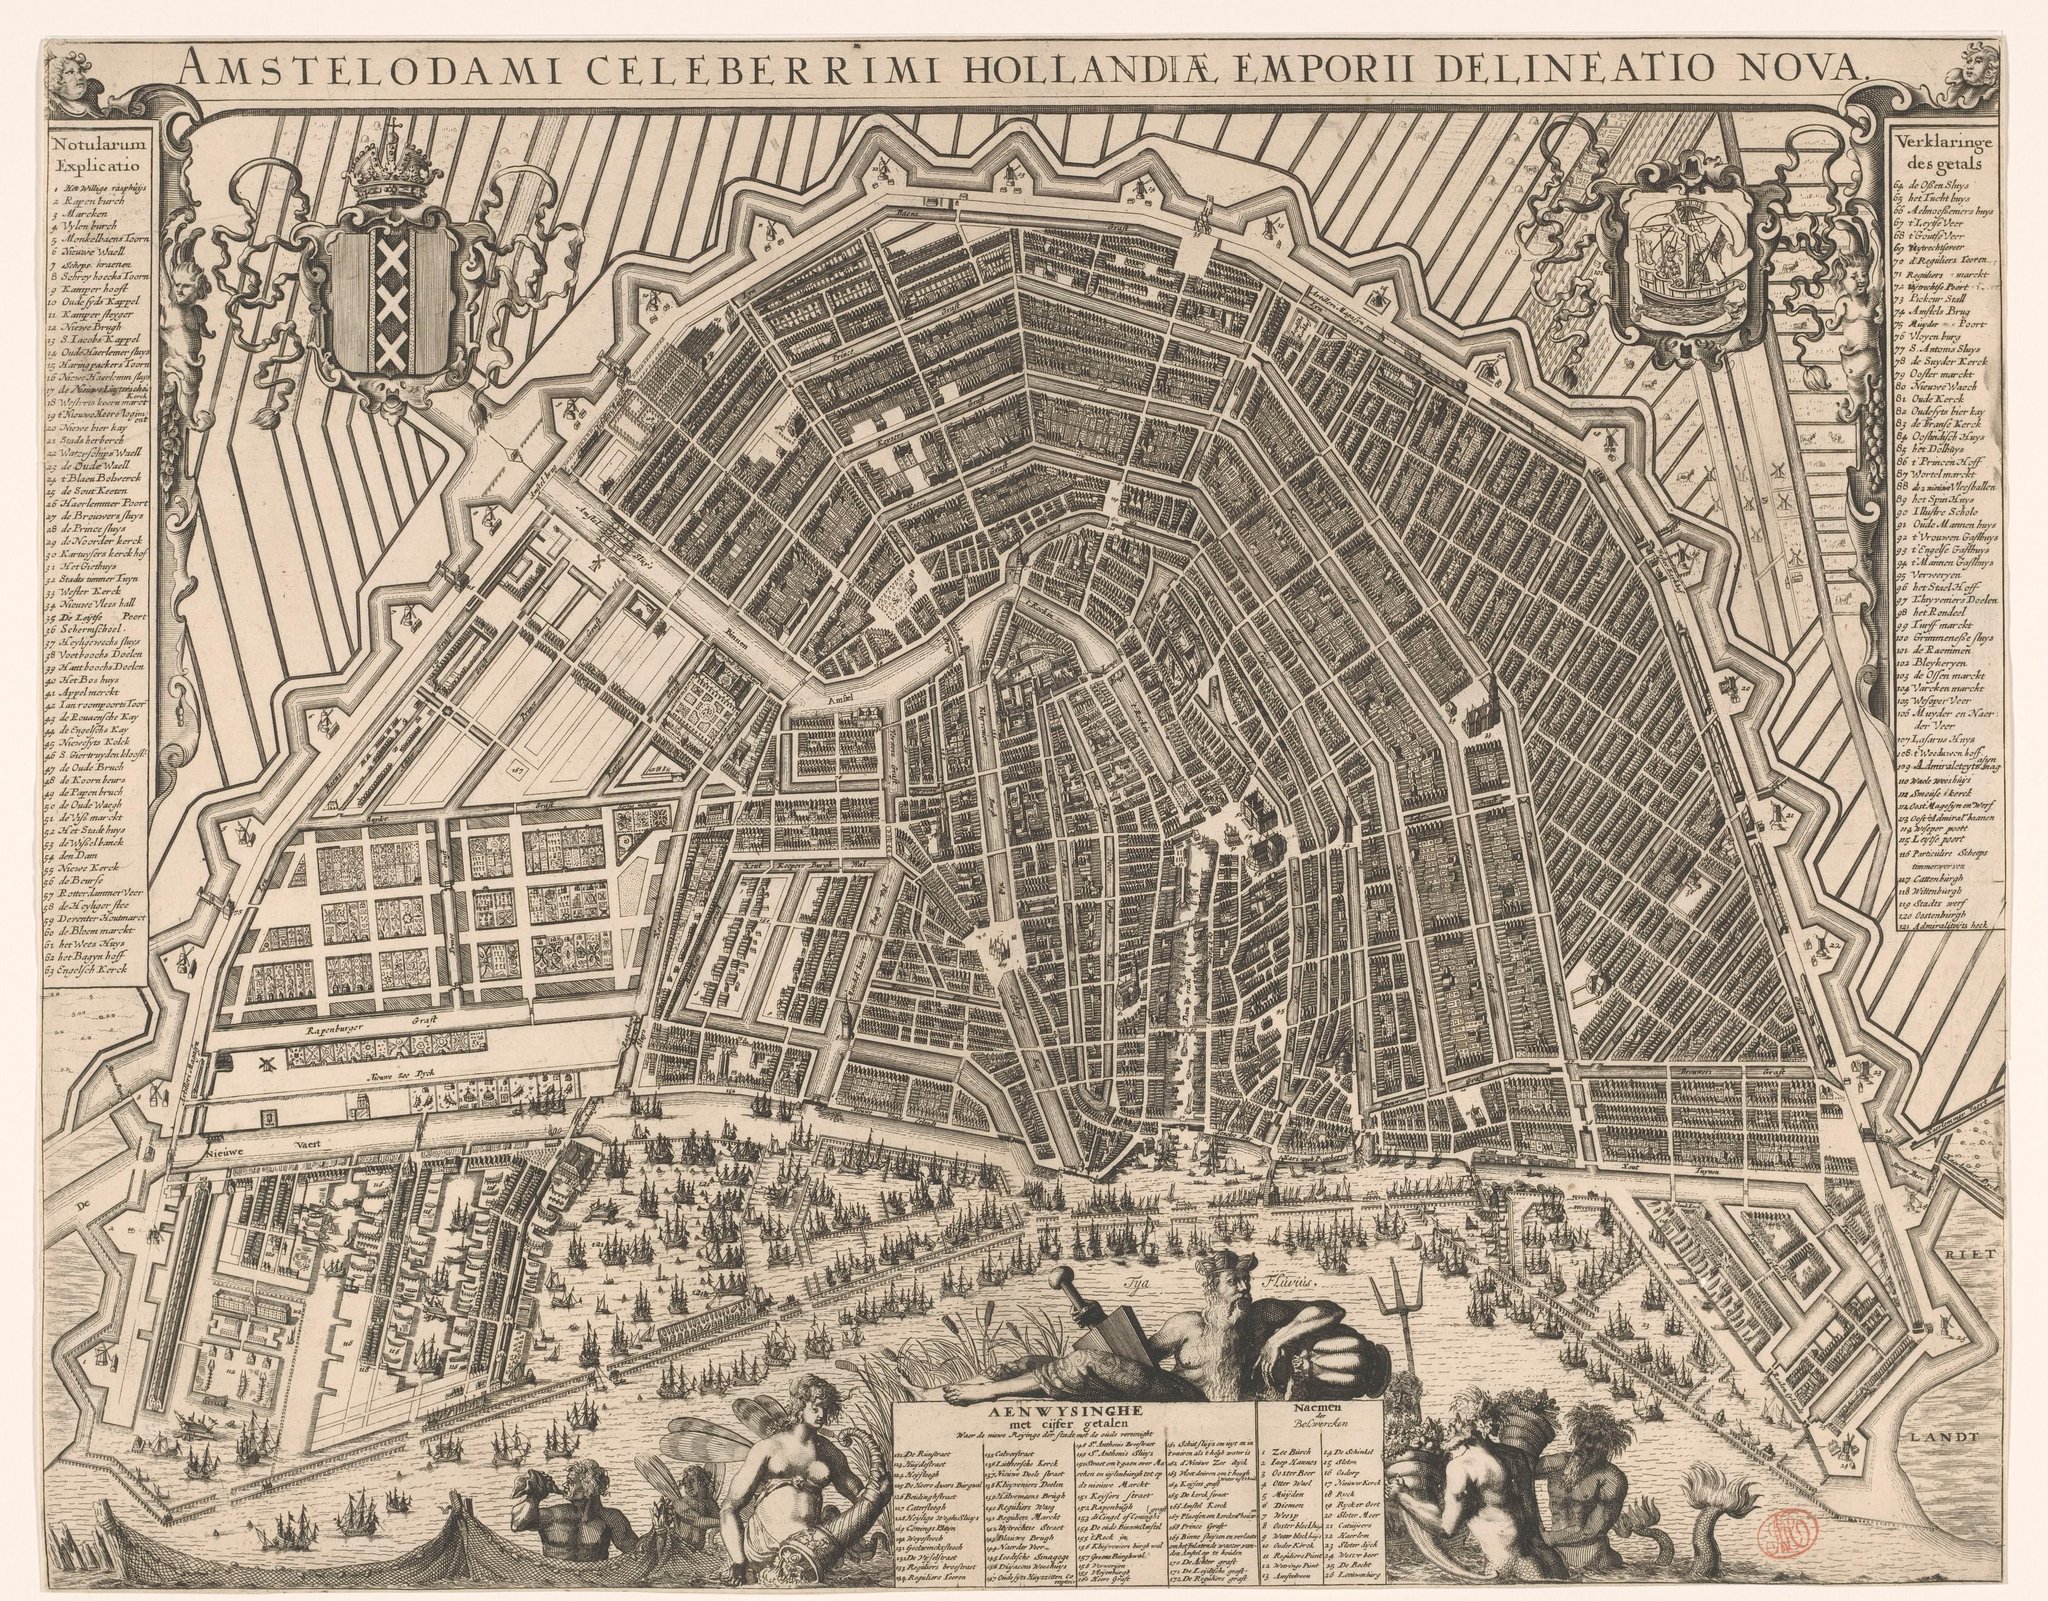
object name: print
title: Plattegrond van Amsterdam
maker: Anonymous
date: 1657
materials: paper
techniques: engraving, etching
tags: coat of arms (as symbol of the state, etc.) (+ city; municipal), triton(s), seal (as symbol of the state, etc.) (+ city; municipal), river-gods, maps of cities, amsterdam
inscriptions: collector's mark: Lugt 195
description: Huidige staat van prent ook gebruikt in: Theatrum ichnographicum omnium urbium et praecipuorum oppidorum Belgicarum XVII Provinciarum (…). Amsterdam: Frederik de Wit, ca. 1698-1704. Huidige staat van prent mogelijk ook gebruikt in: Tooneel der vermaarste koop-steden en handelsplaatsen van de geheele wereld. 2 delen. Amsterdam: erven Johannes Janssonius van Waesberge (I) / Johannes Janssonius van Waesberge (II), 1682, dl. 1. En in: Leti, Gregorio. Teatro Belgico o vero ritratti historici, chronologici, politici e geografici delle Sette Provincie Unite. 2 delen. Amsterdam: Willem de Jonge, 1690. Het is ook mogelijk dat de tweede staat van deze prent gebruikt is in deze publicaties.